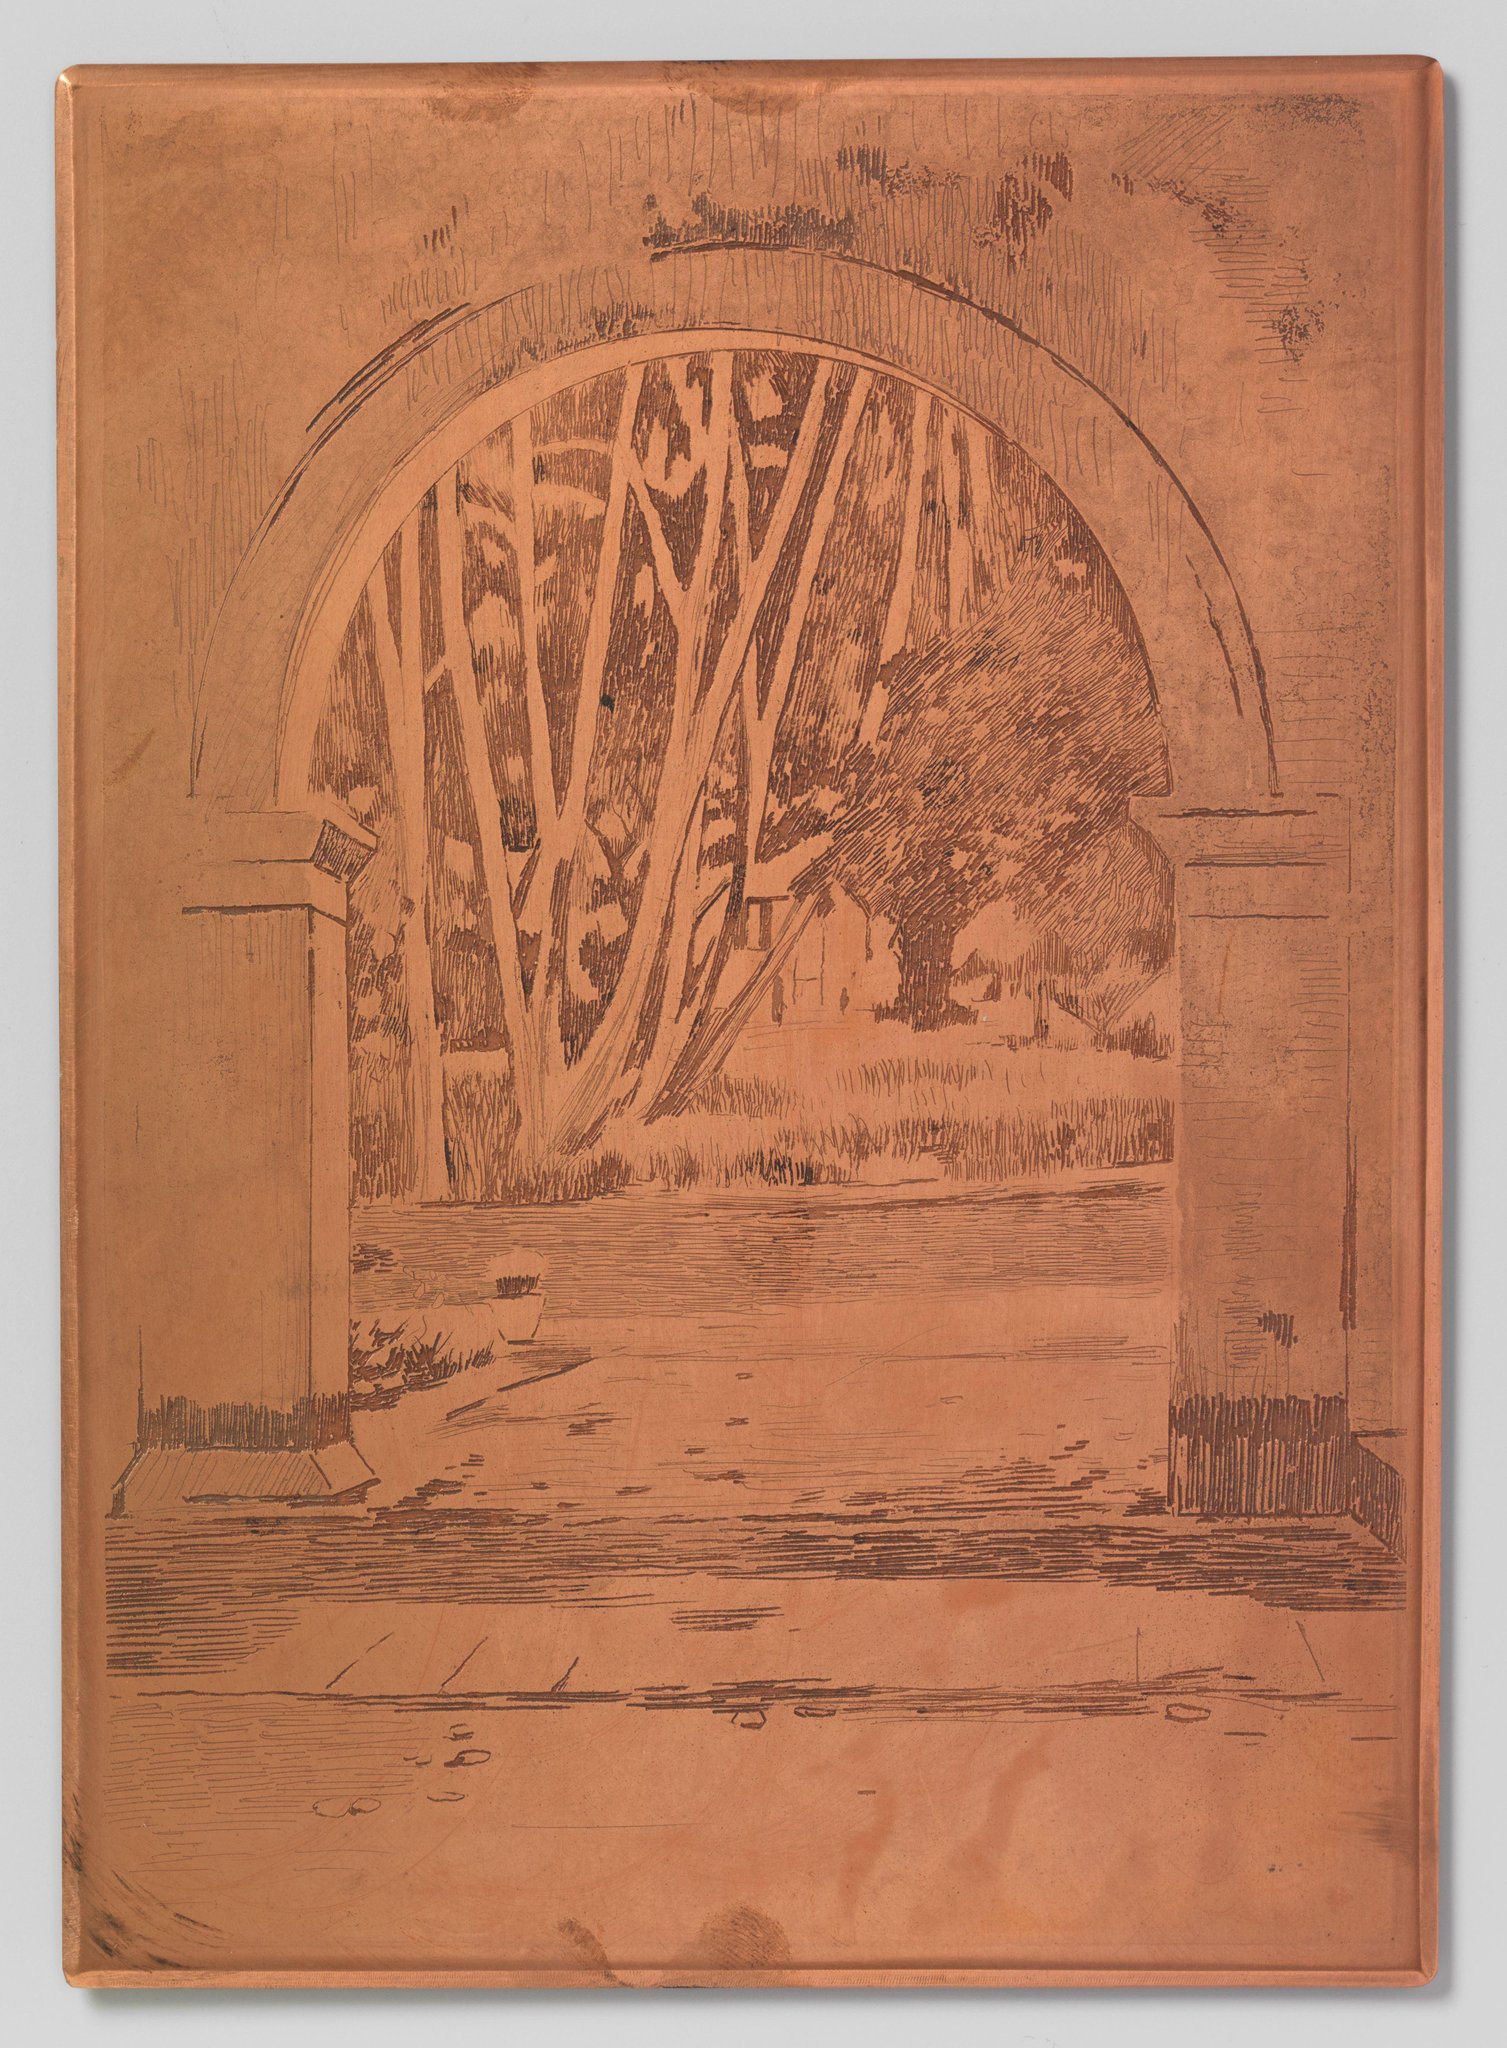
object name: copper plate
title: Poortje, Hotel Bellevue, Buitenzorg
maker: willem witsen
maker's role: draughtsman, painter, print maker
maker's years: 1860-1923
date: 1921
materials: copper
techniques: etching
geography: buitenzorg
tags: buitenzorg